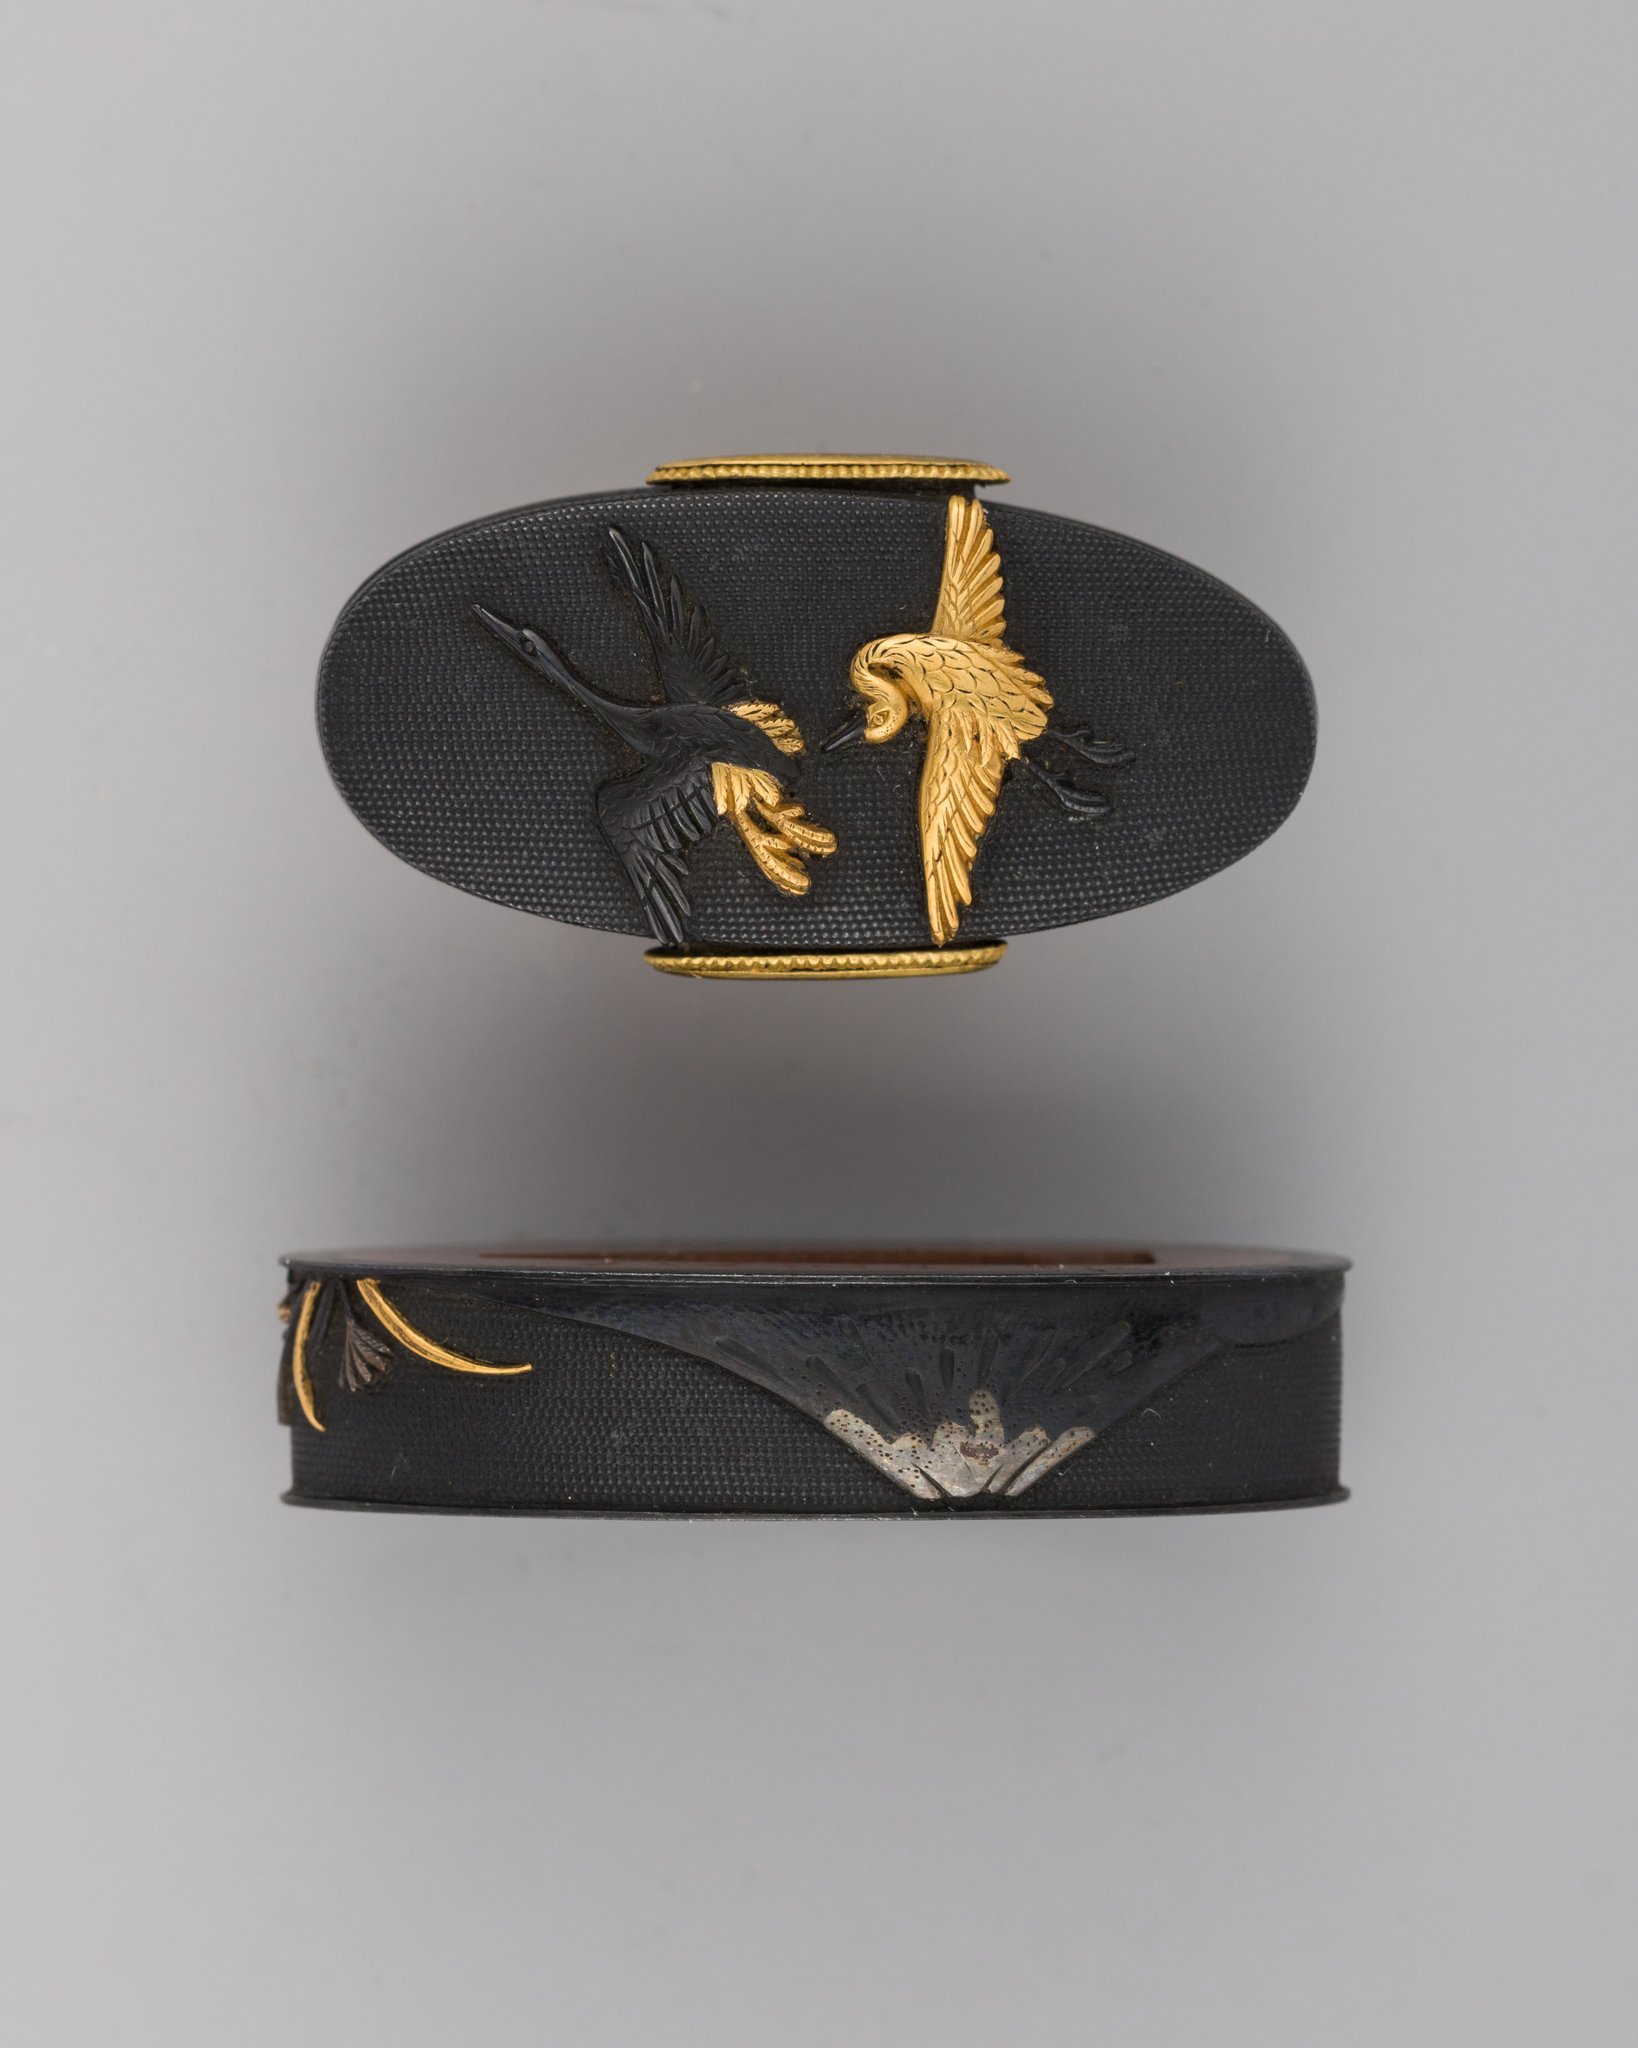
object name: sword hilt collar and pommel fuchigashira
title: Sword-Hilt Collar and Pommel (Fuchigashira)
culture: japanese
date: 1801-1900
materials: gold alloy, gold, silver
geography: japan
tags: cranes